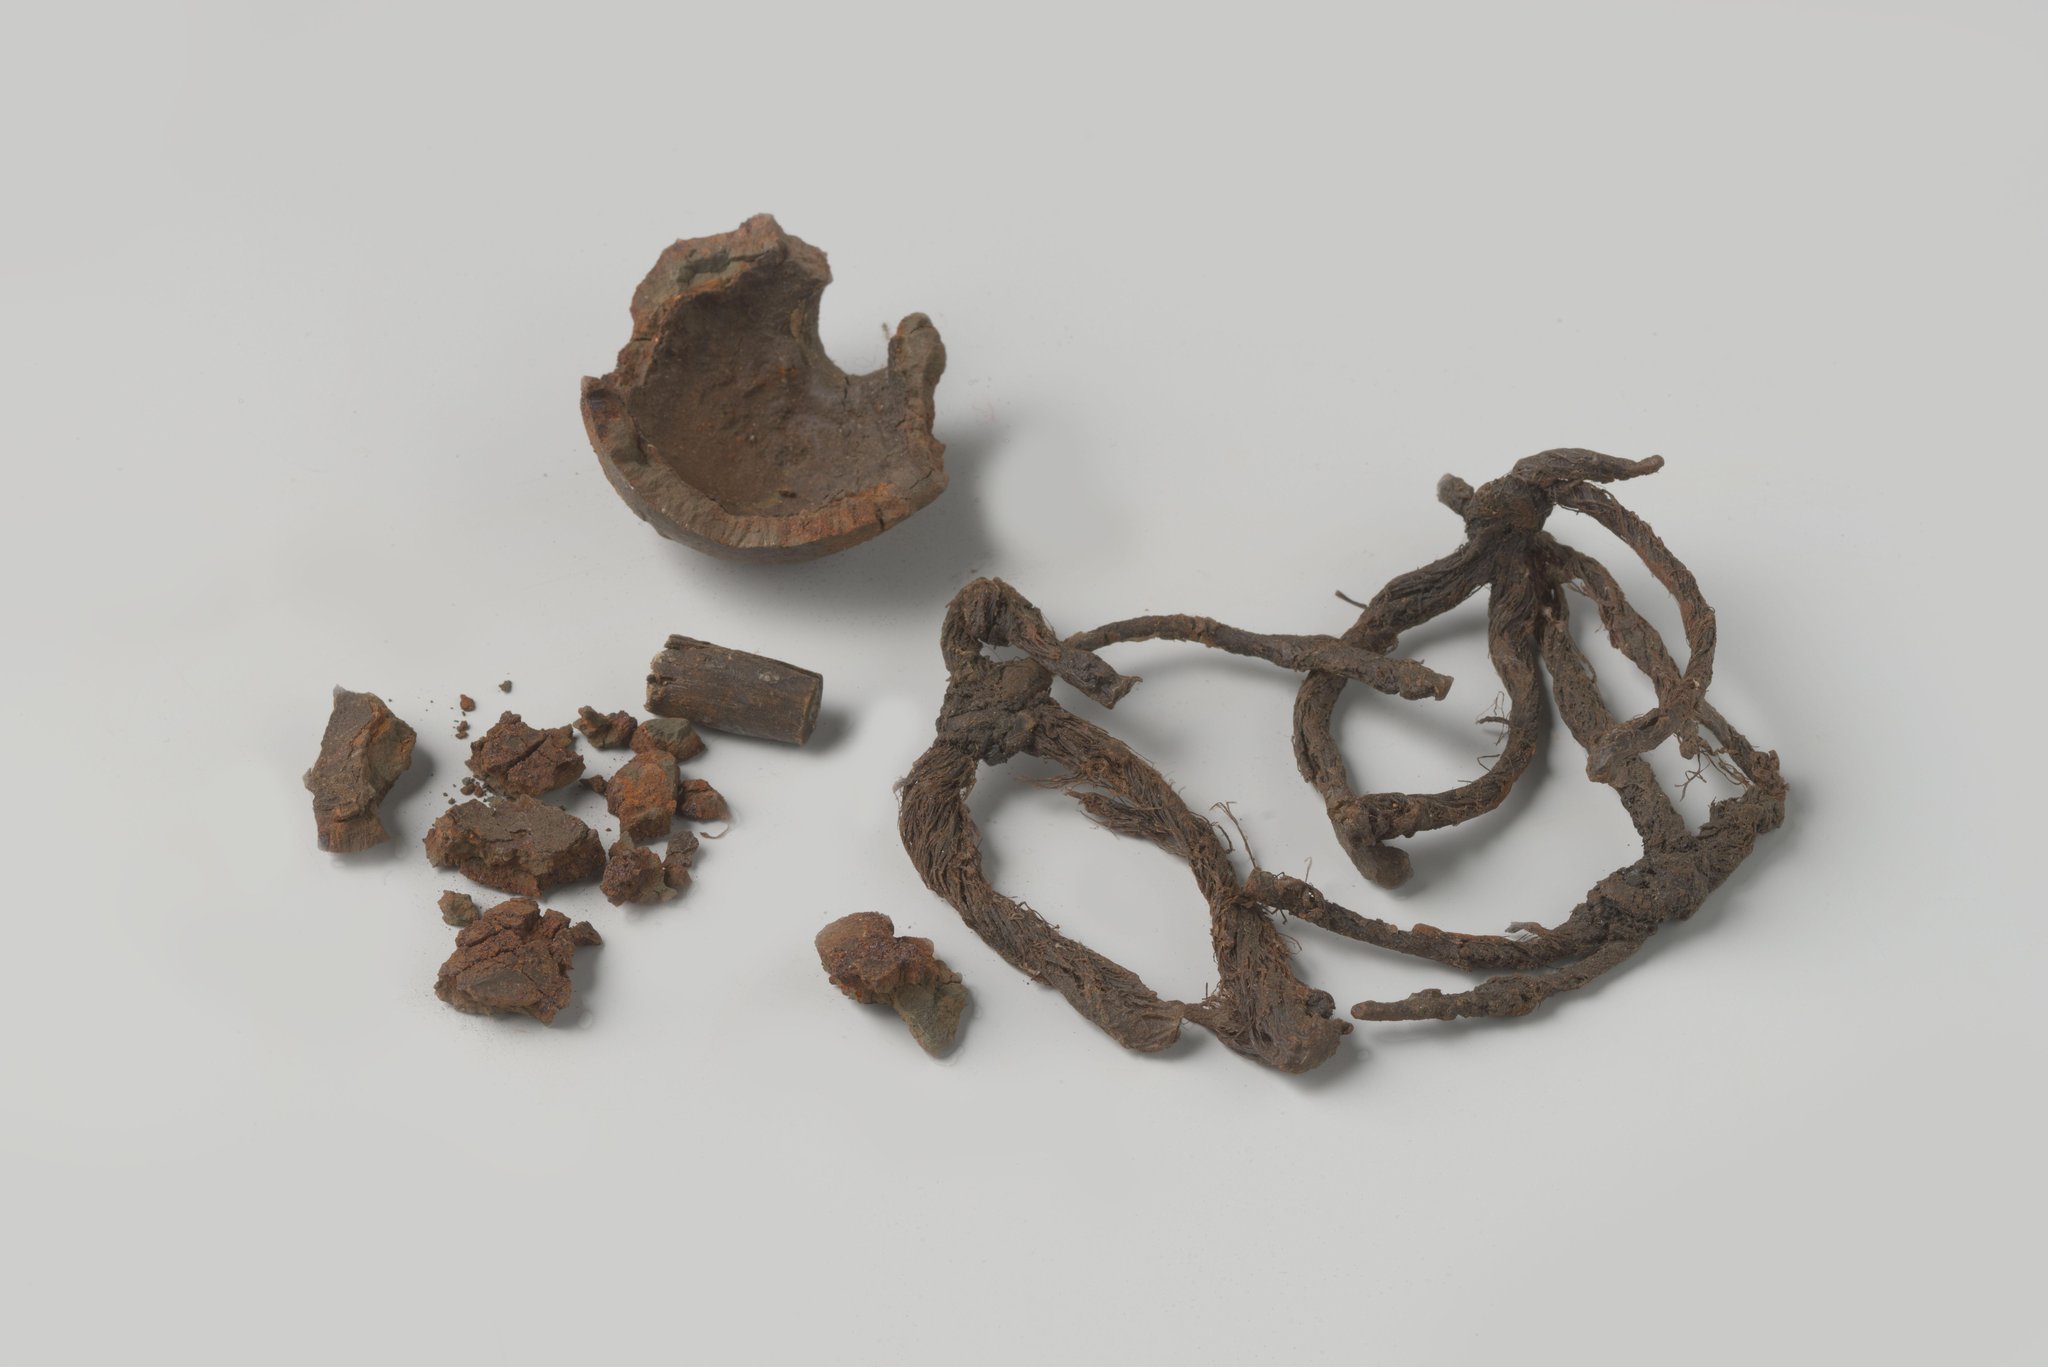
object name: bullet ammunition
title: Zeven kogels uit het wrak van de Oostindiëvaarder Hollandia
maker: Anonymous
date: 1700-1743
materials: iron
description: Kogels, waarvan vier ernstig gecorrodeerd.